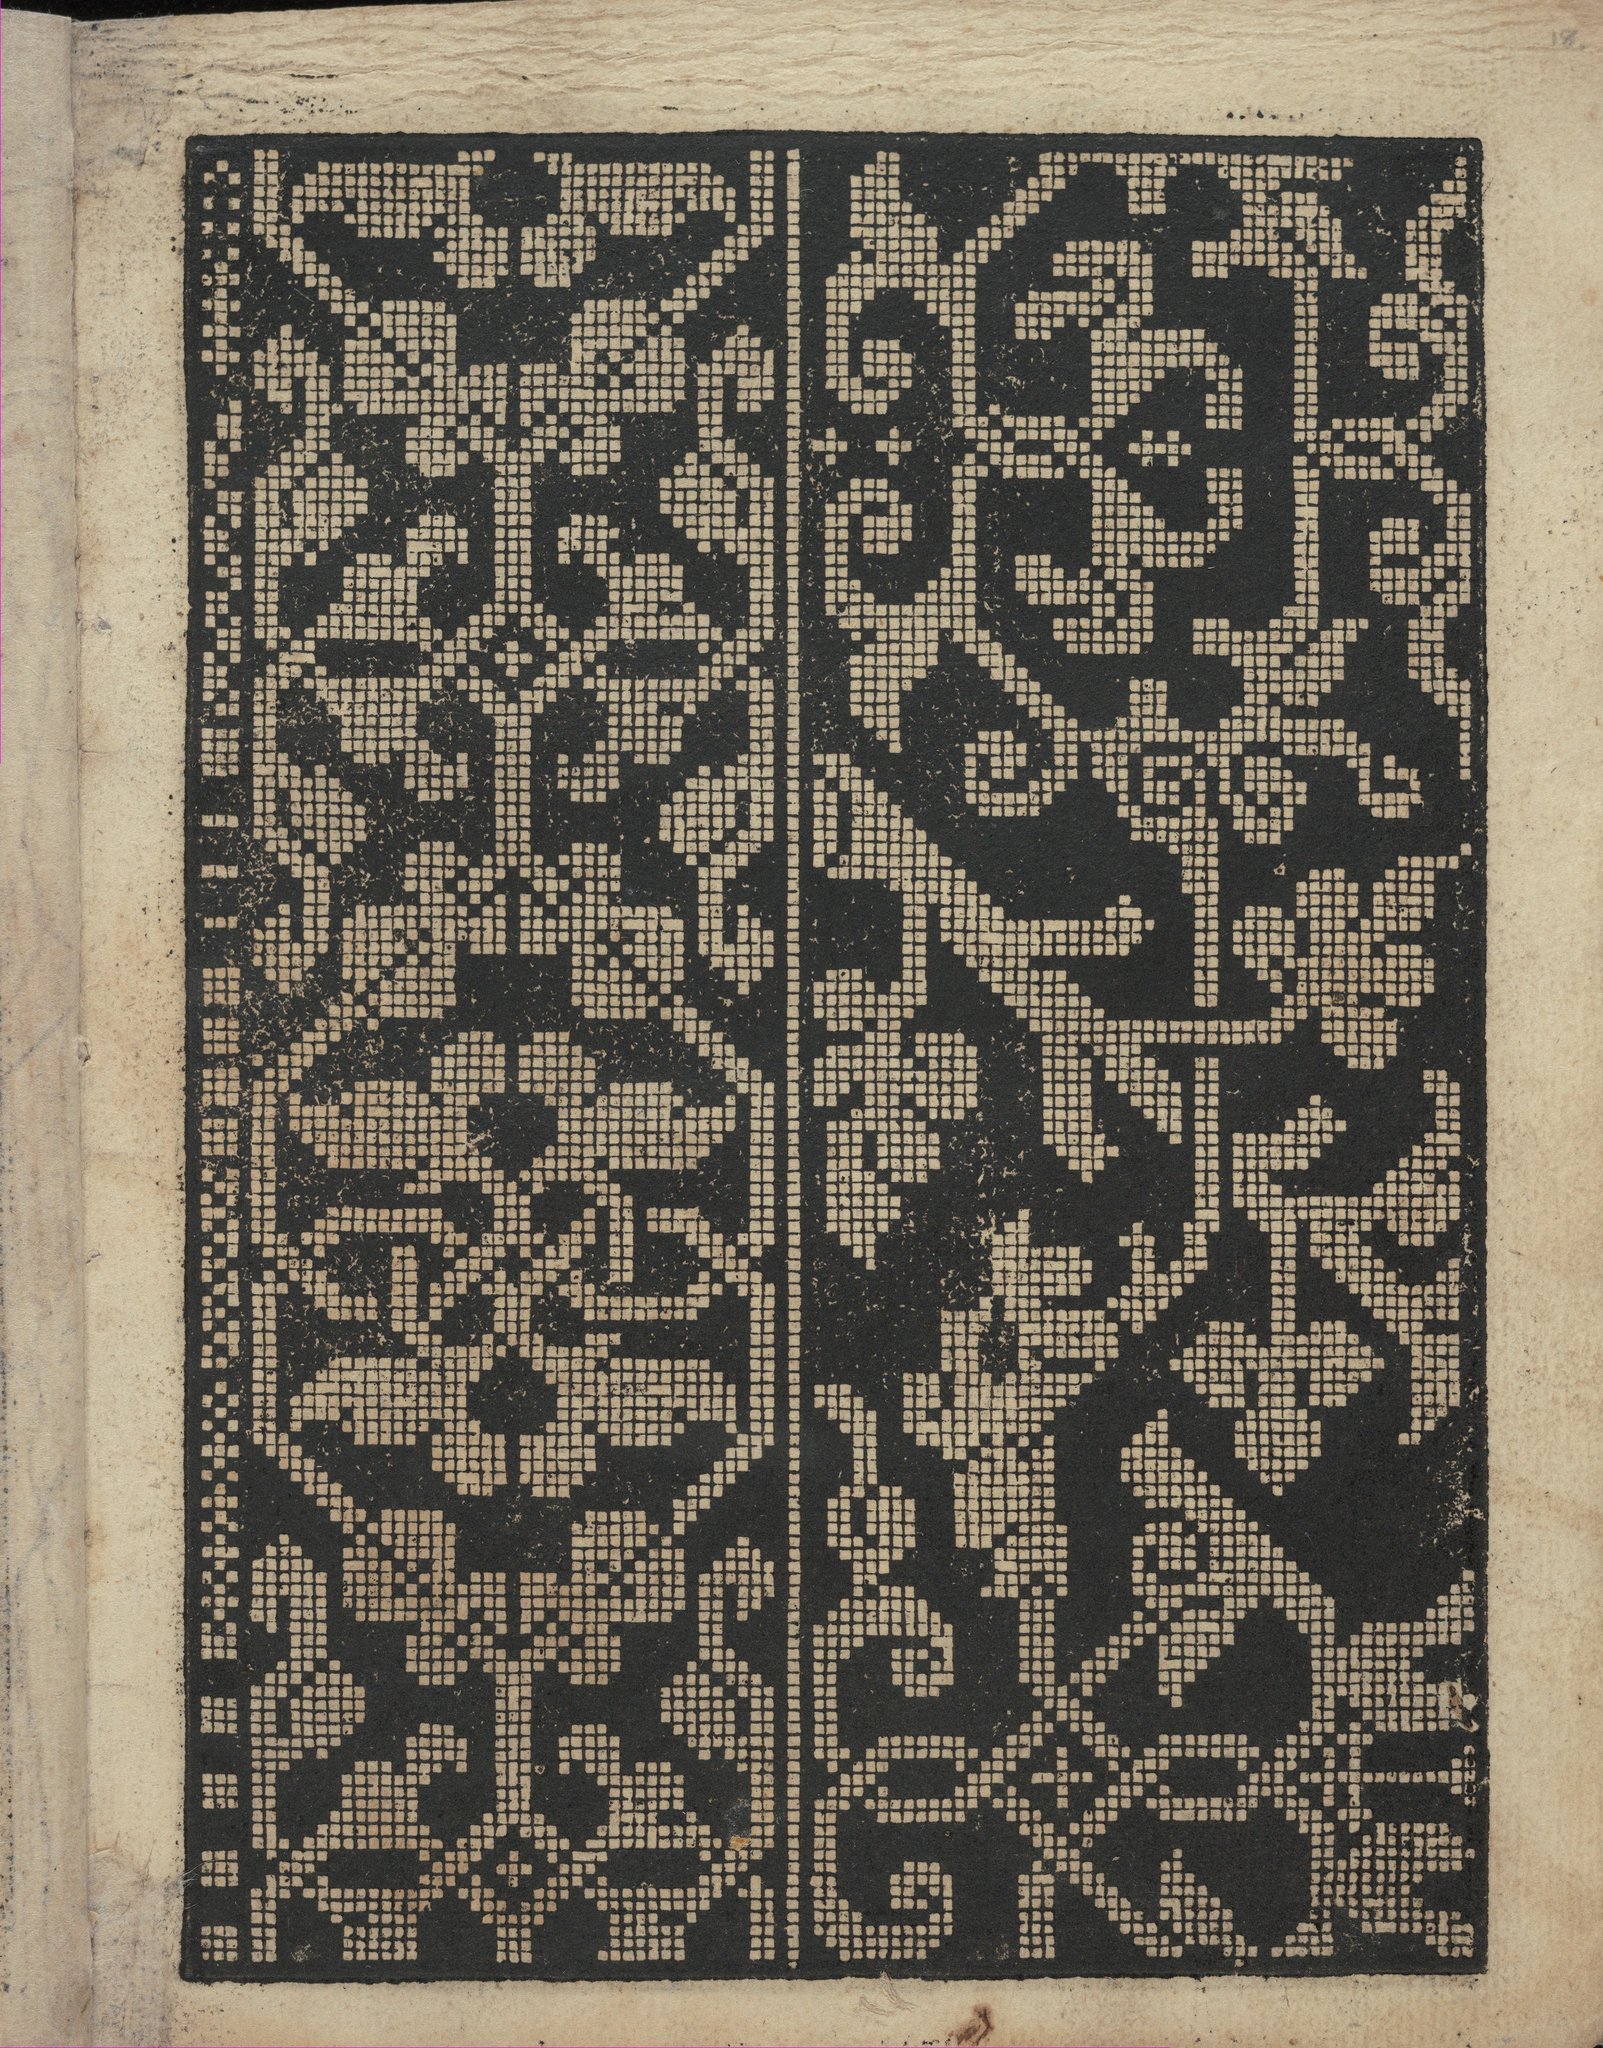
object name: book print ornament architecture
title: Libbretto nouellamete composto per maestro Domenico da Sera...lauorare di ogni sorte di punti, page 18 (recto)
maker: domenico da sera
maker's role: publisher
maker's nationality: french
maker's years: 1500-1599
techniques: woodcut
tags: flowers